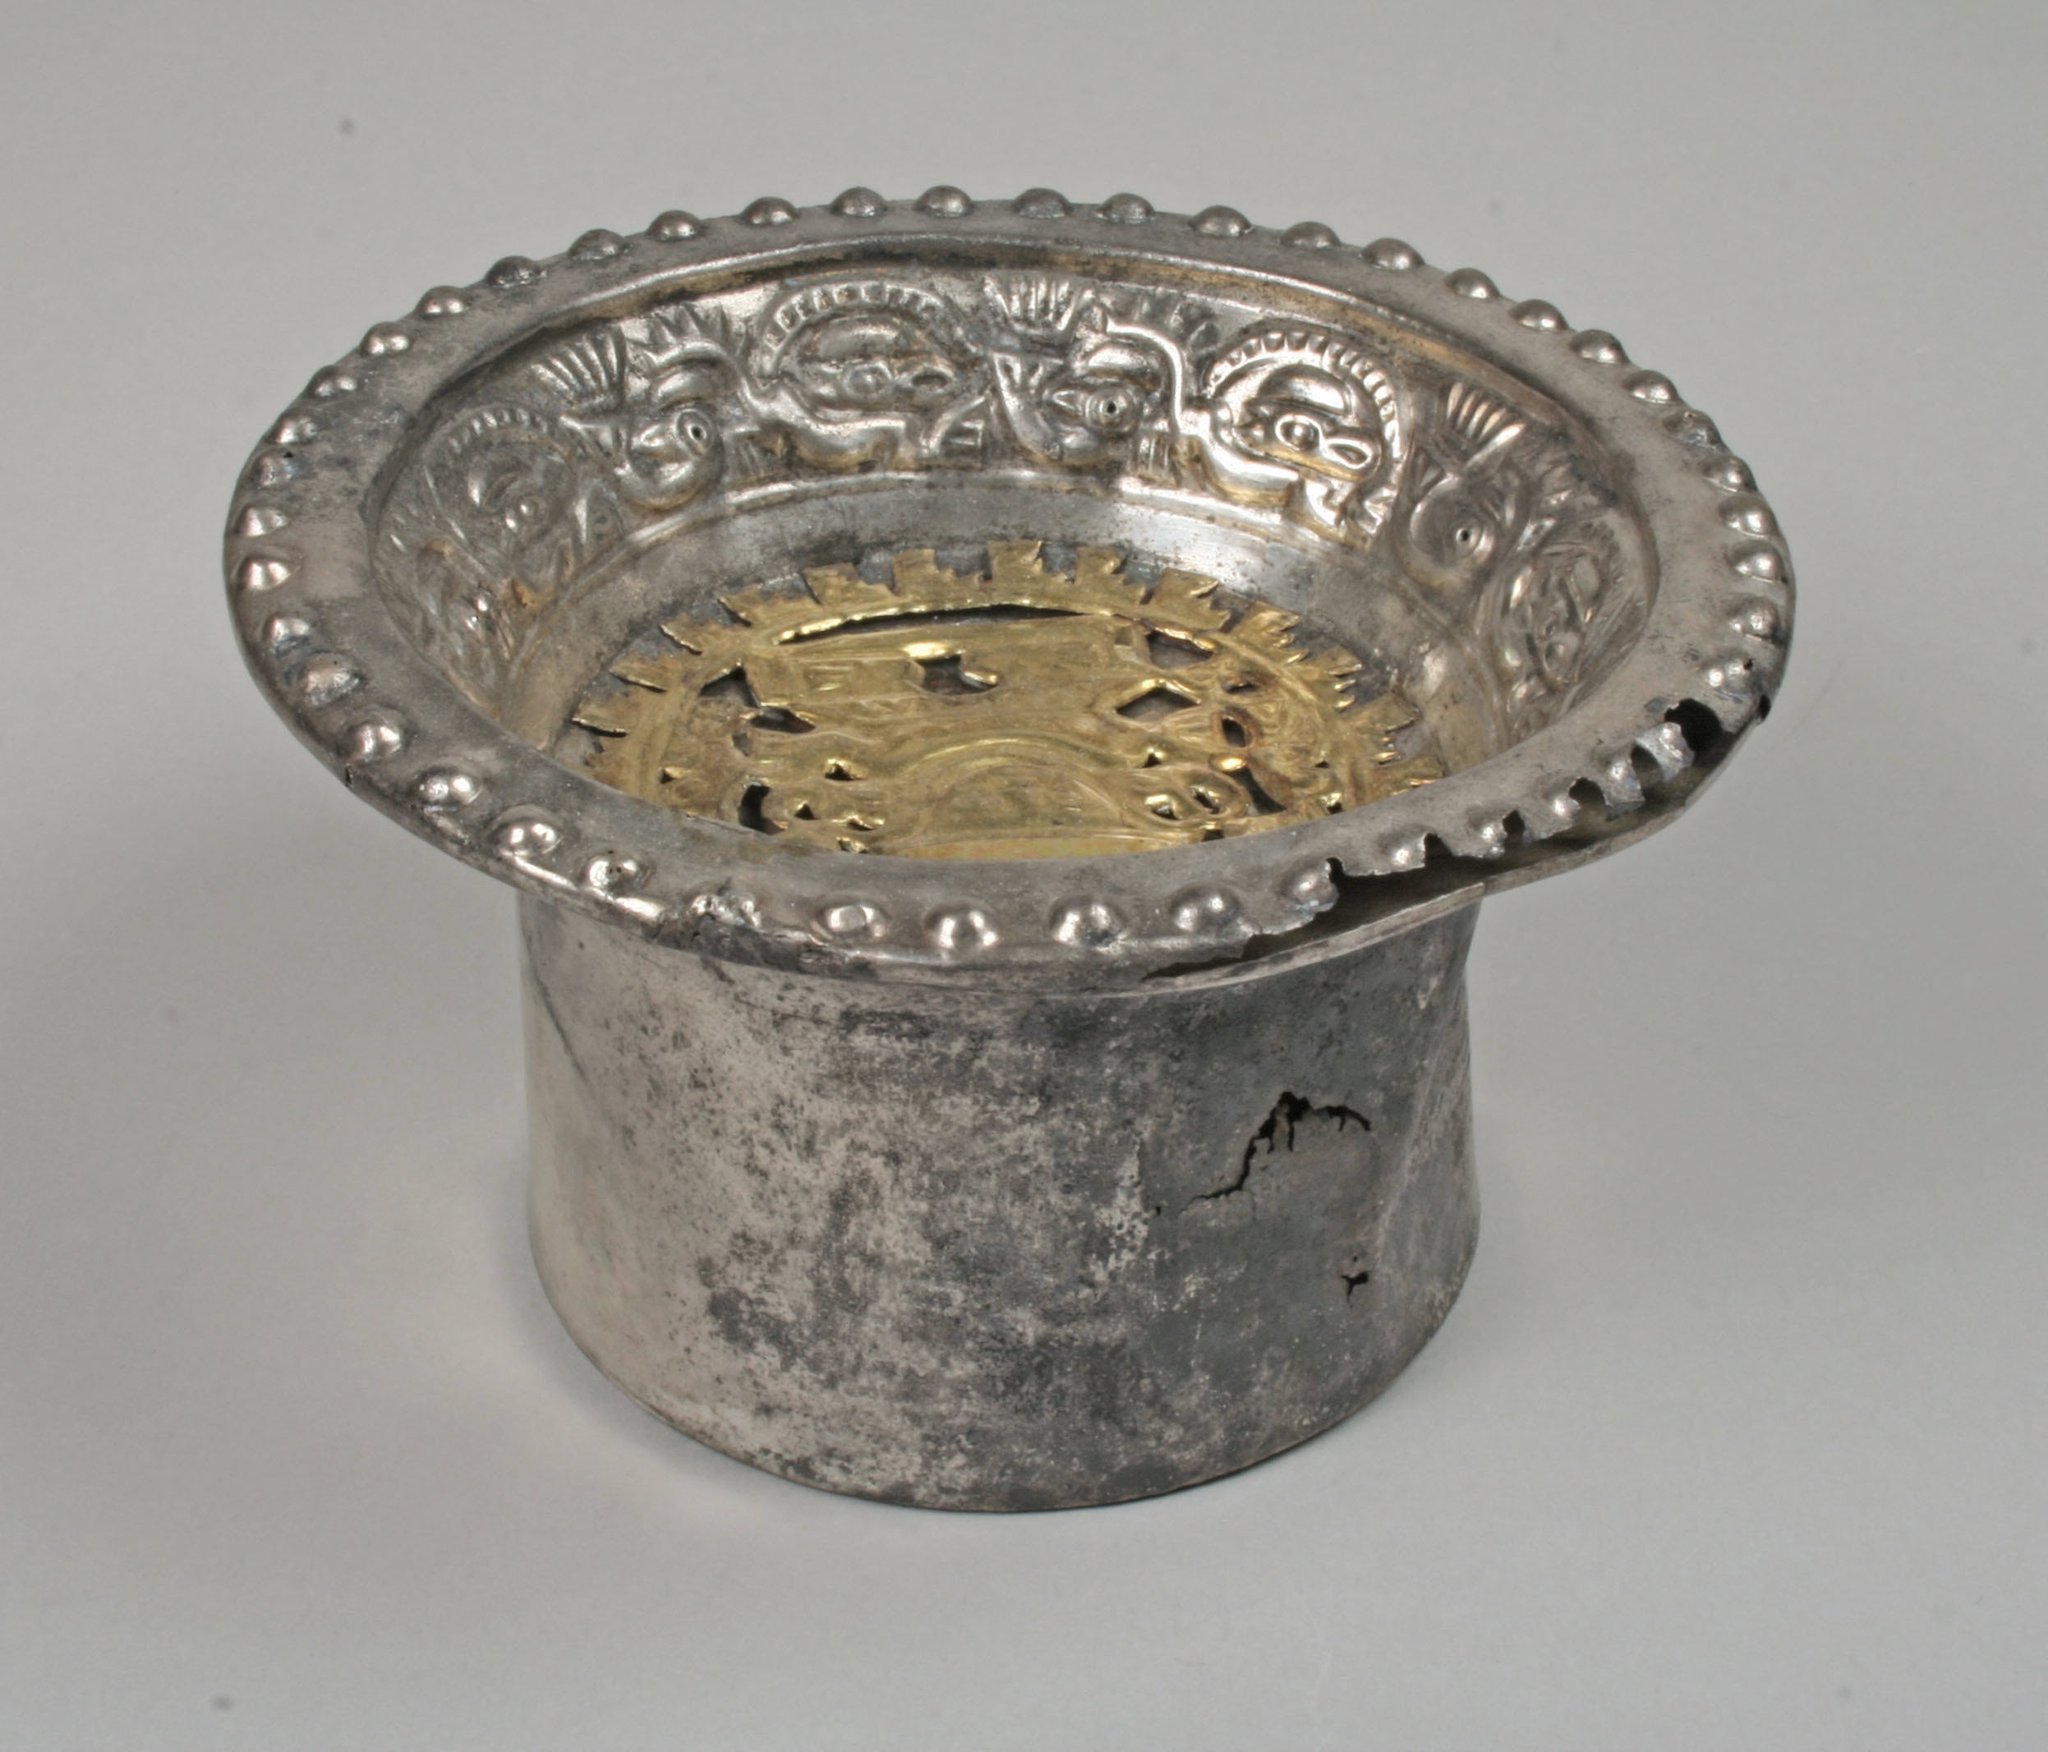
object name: earflare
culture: chimú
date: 1301-1500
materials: gold, silver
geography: peru